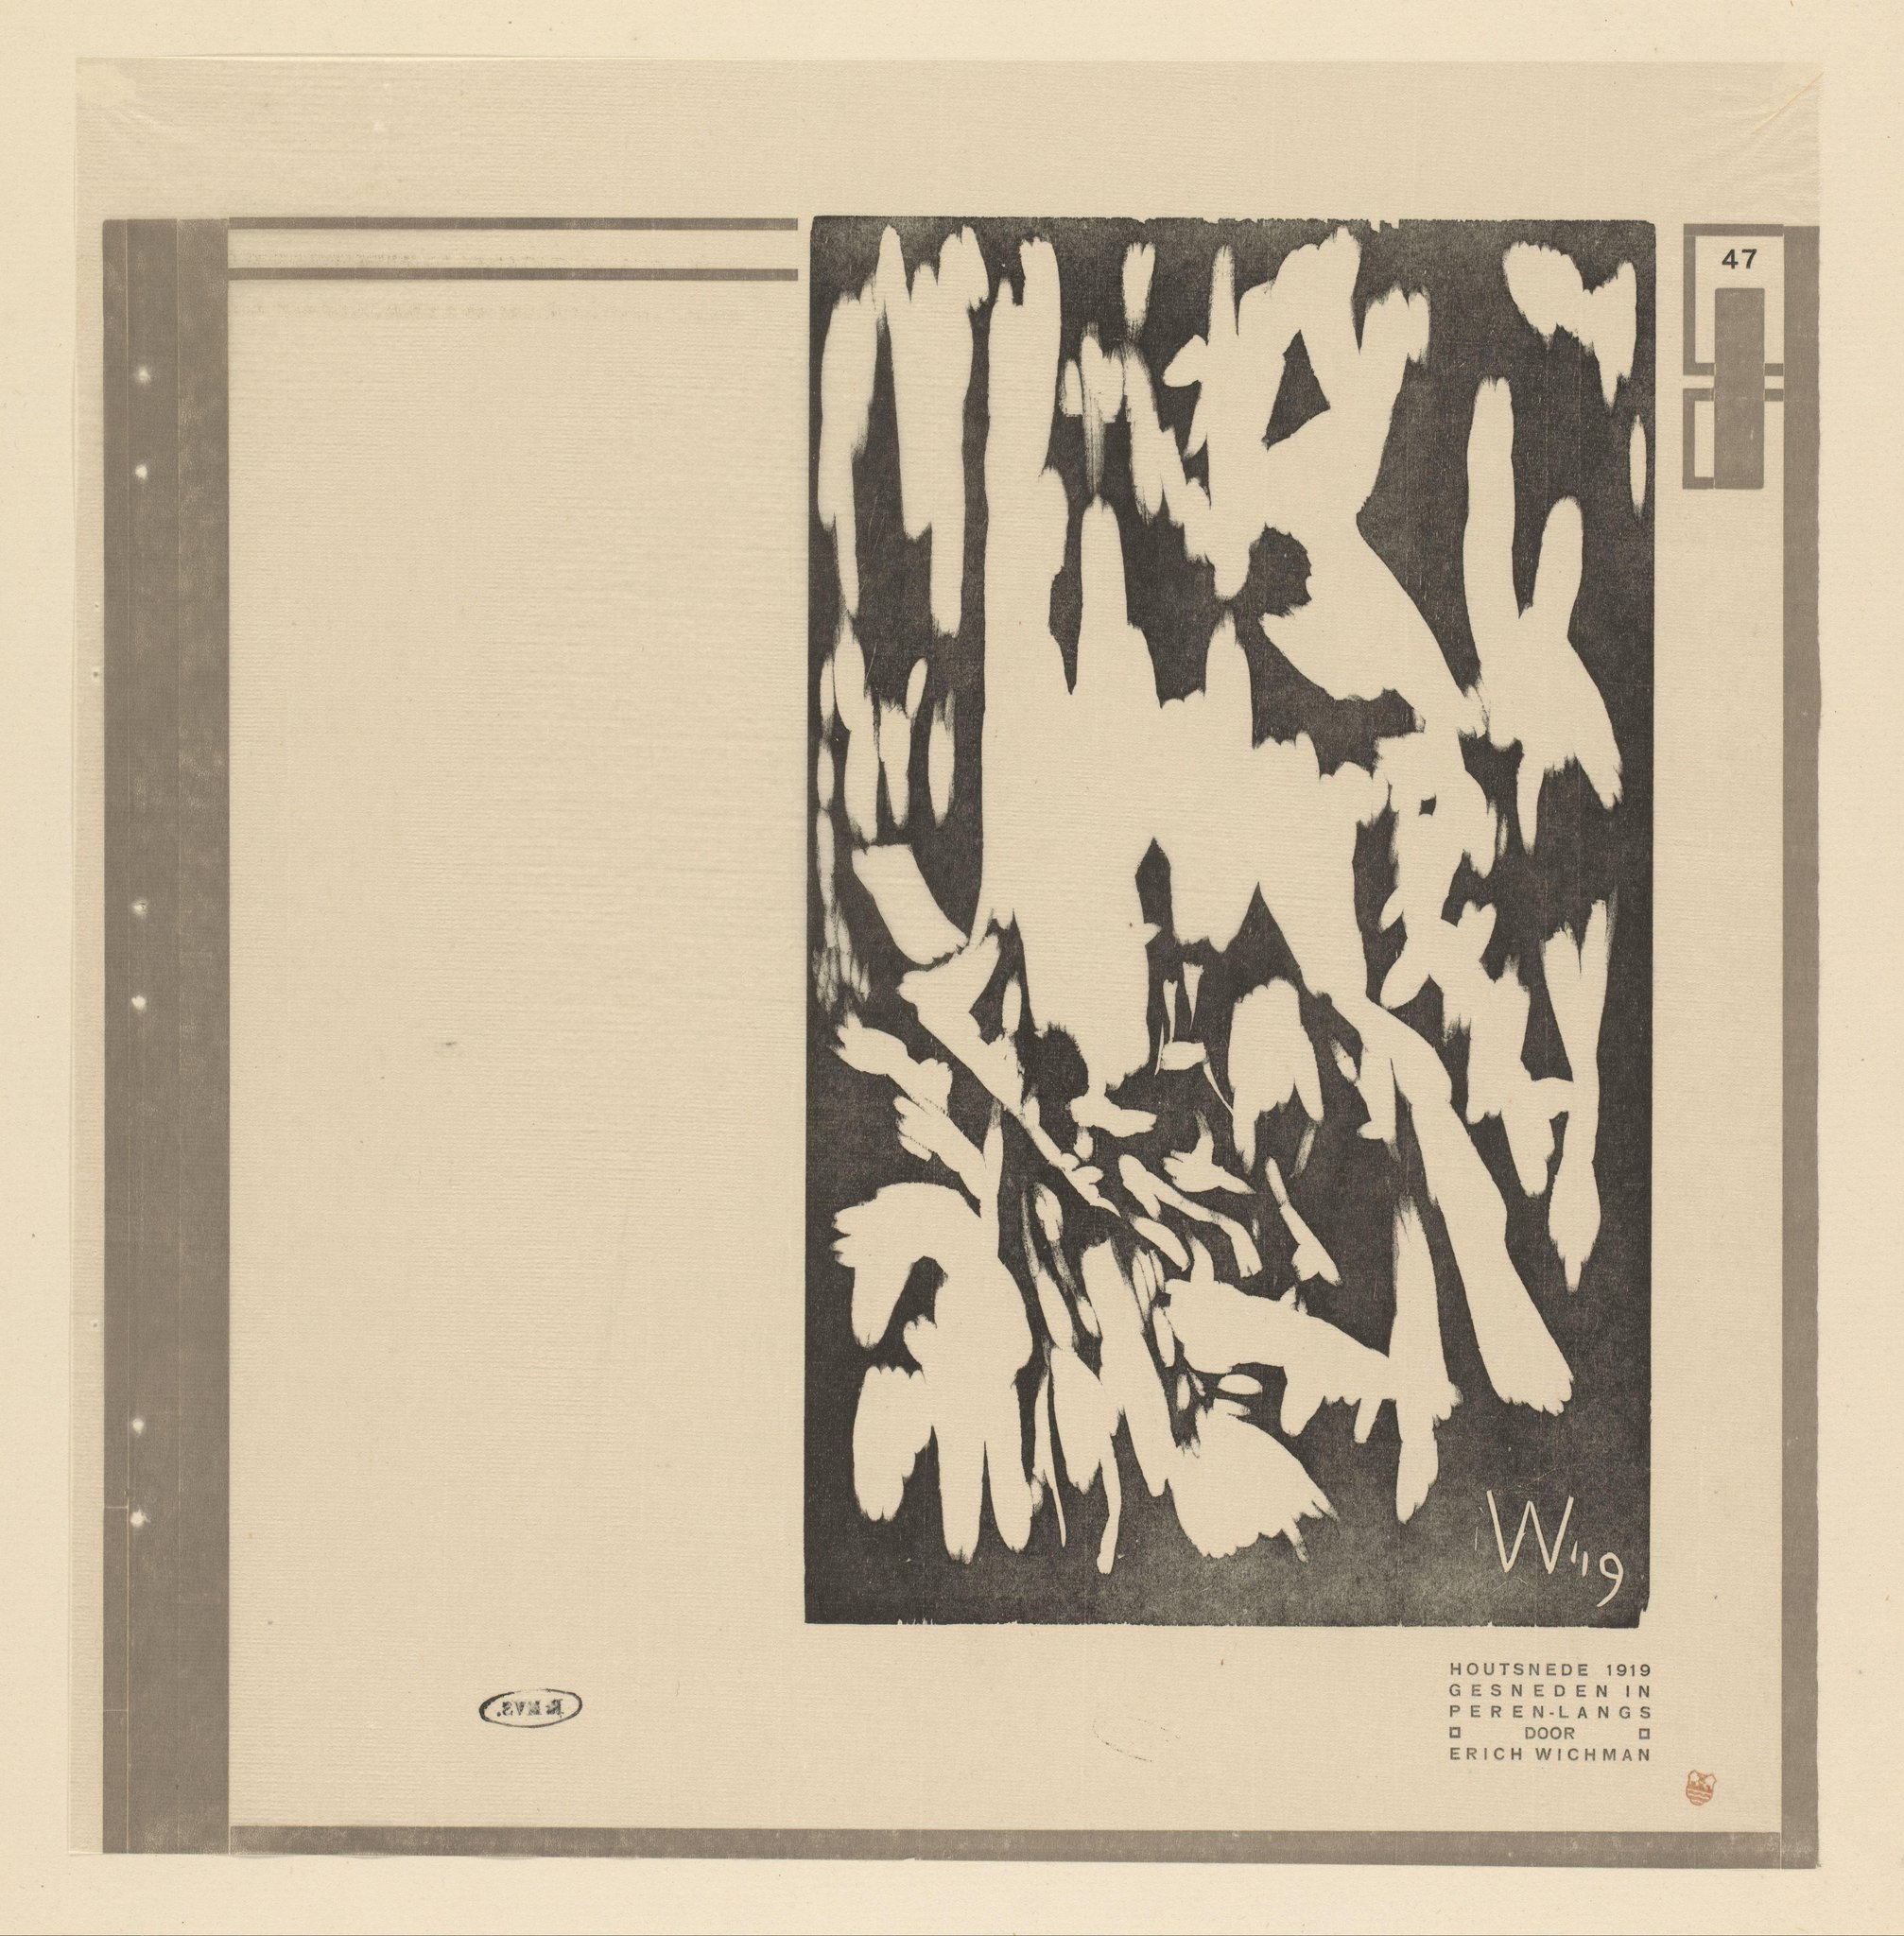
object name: print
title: Compositie van lijnen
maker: erich wichmann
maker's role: print maker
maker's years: 1890-1929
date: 1919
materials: paper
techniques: woodcut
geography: amsterdam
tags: abstract, non-representational art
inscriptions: collector's mark: Lugt 2760, collector's mark: Lugt 2228